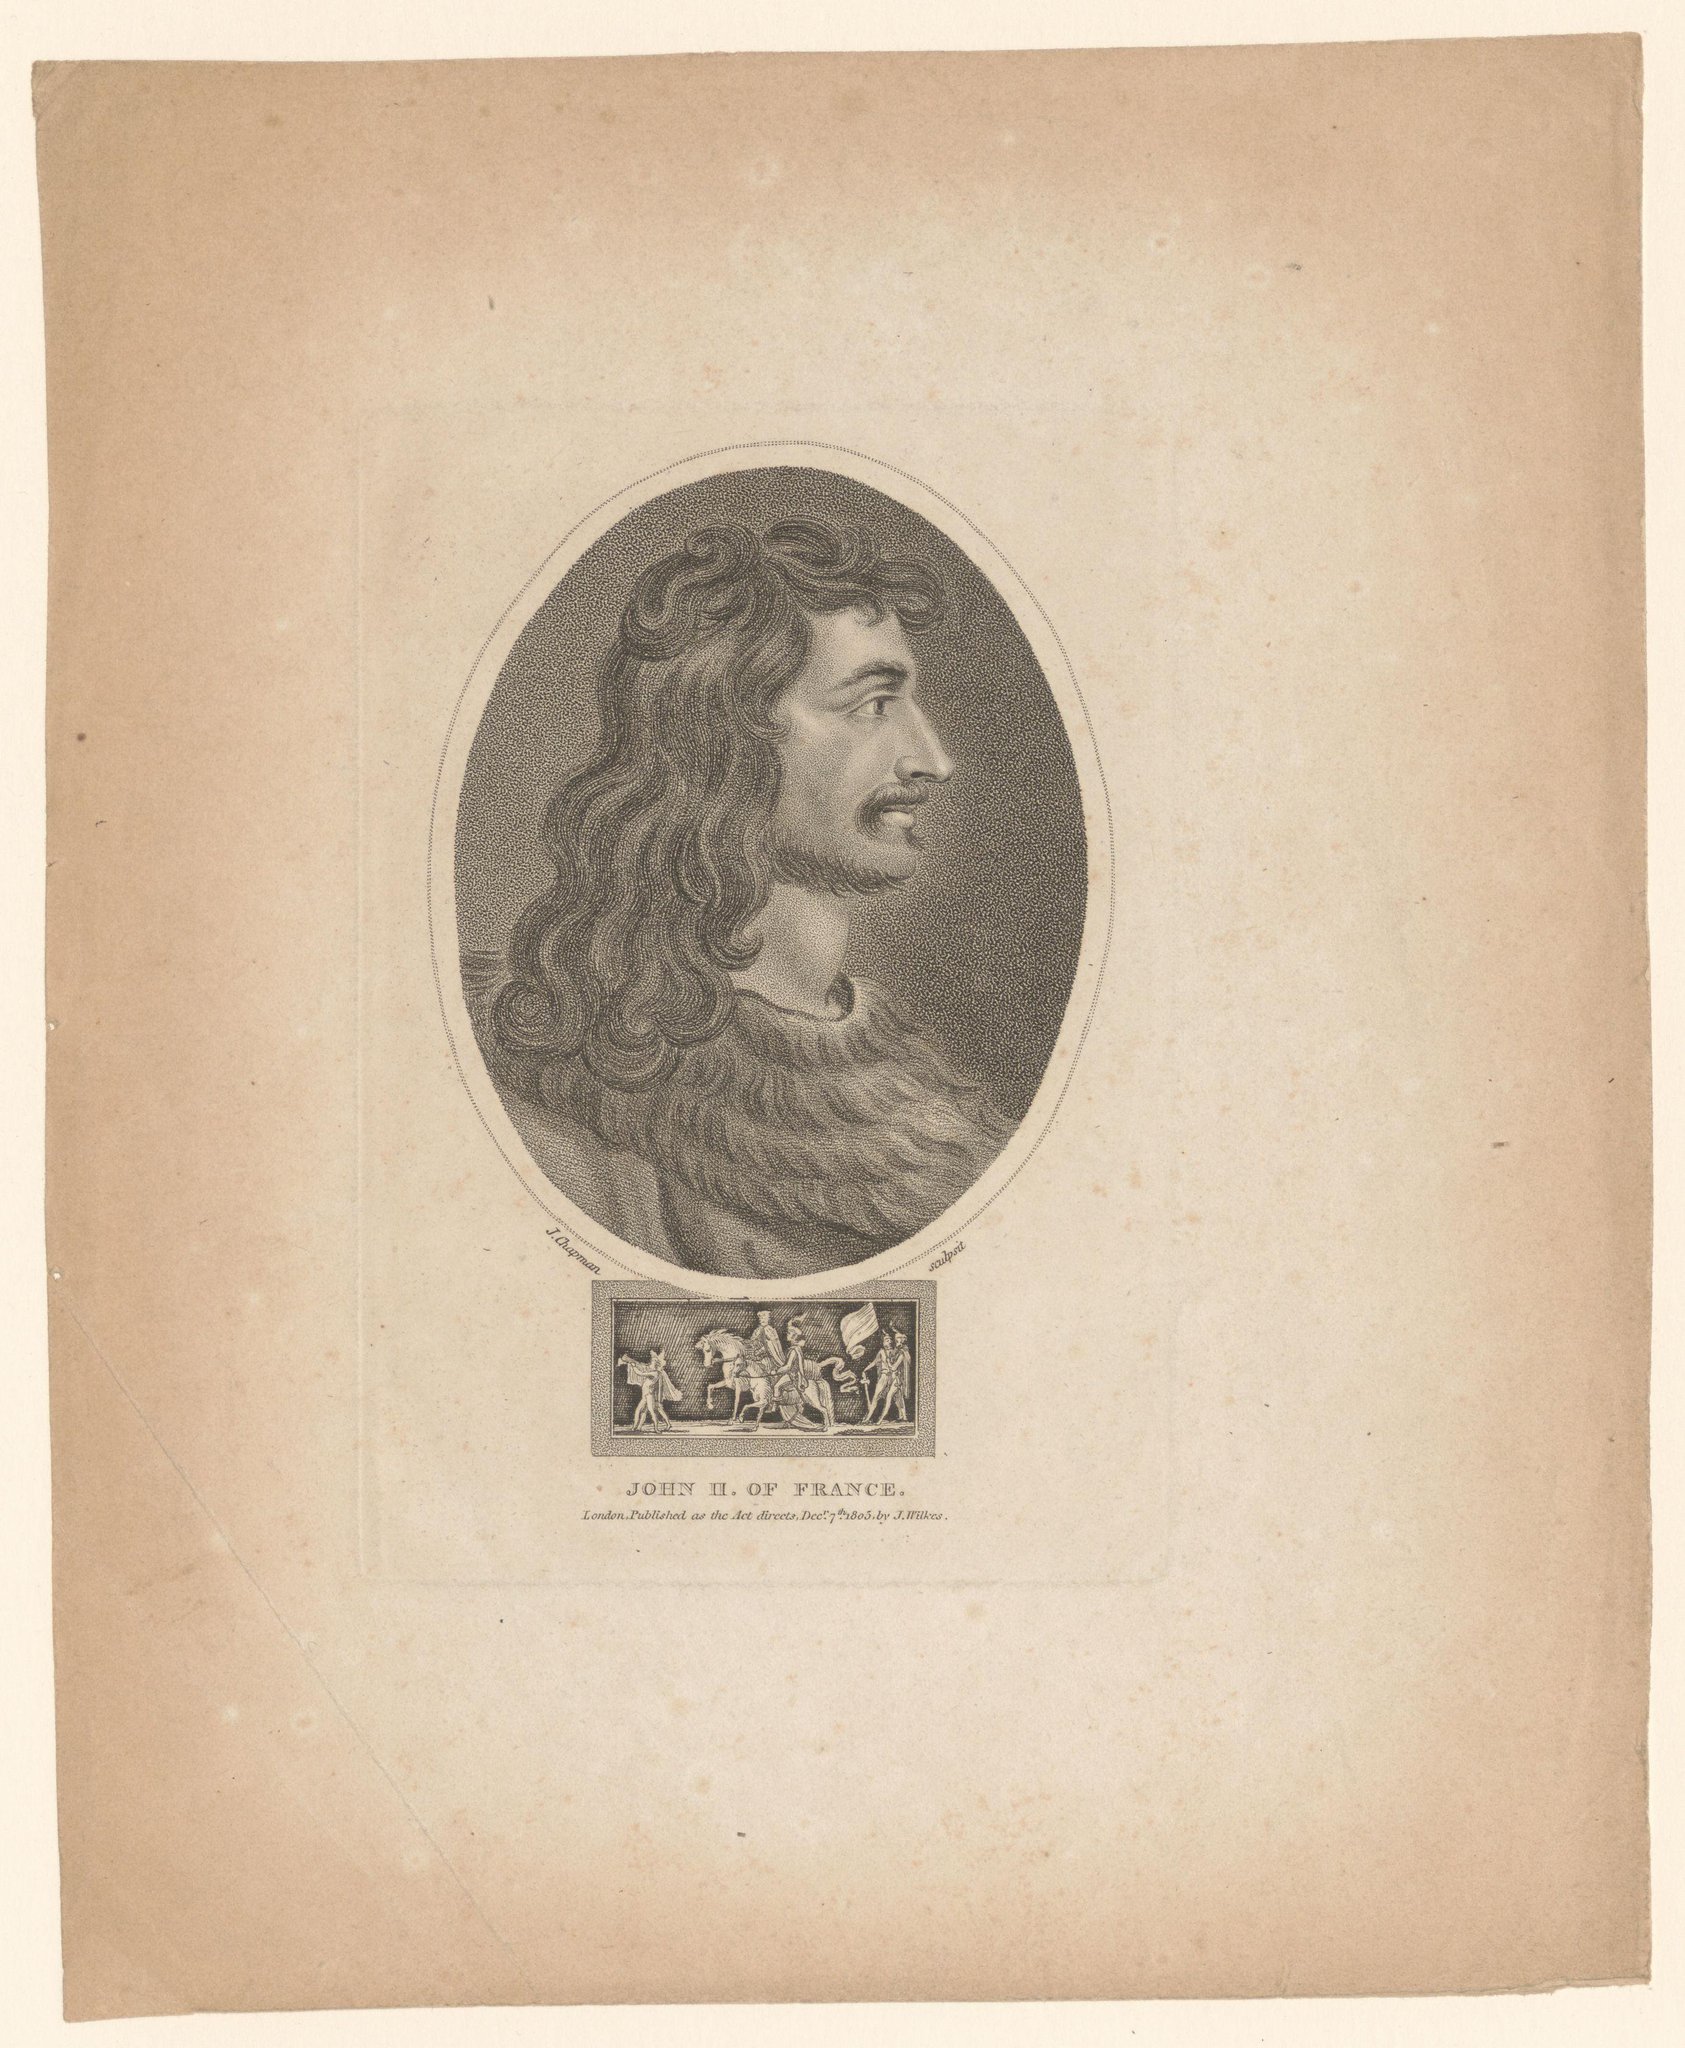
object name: print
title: Portret van Jan II, koning van Frankrijk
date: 1805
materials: paper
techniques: stippling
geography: london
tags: triumphal entry and public reception, pageant, 'entrée solennelle', 'joyeuse entrée', historical persons, king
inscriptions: collector's mark: Lugt 2228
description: Deze prent maakt mogelijk deel uit van een reeks met portretten van koningen.